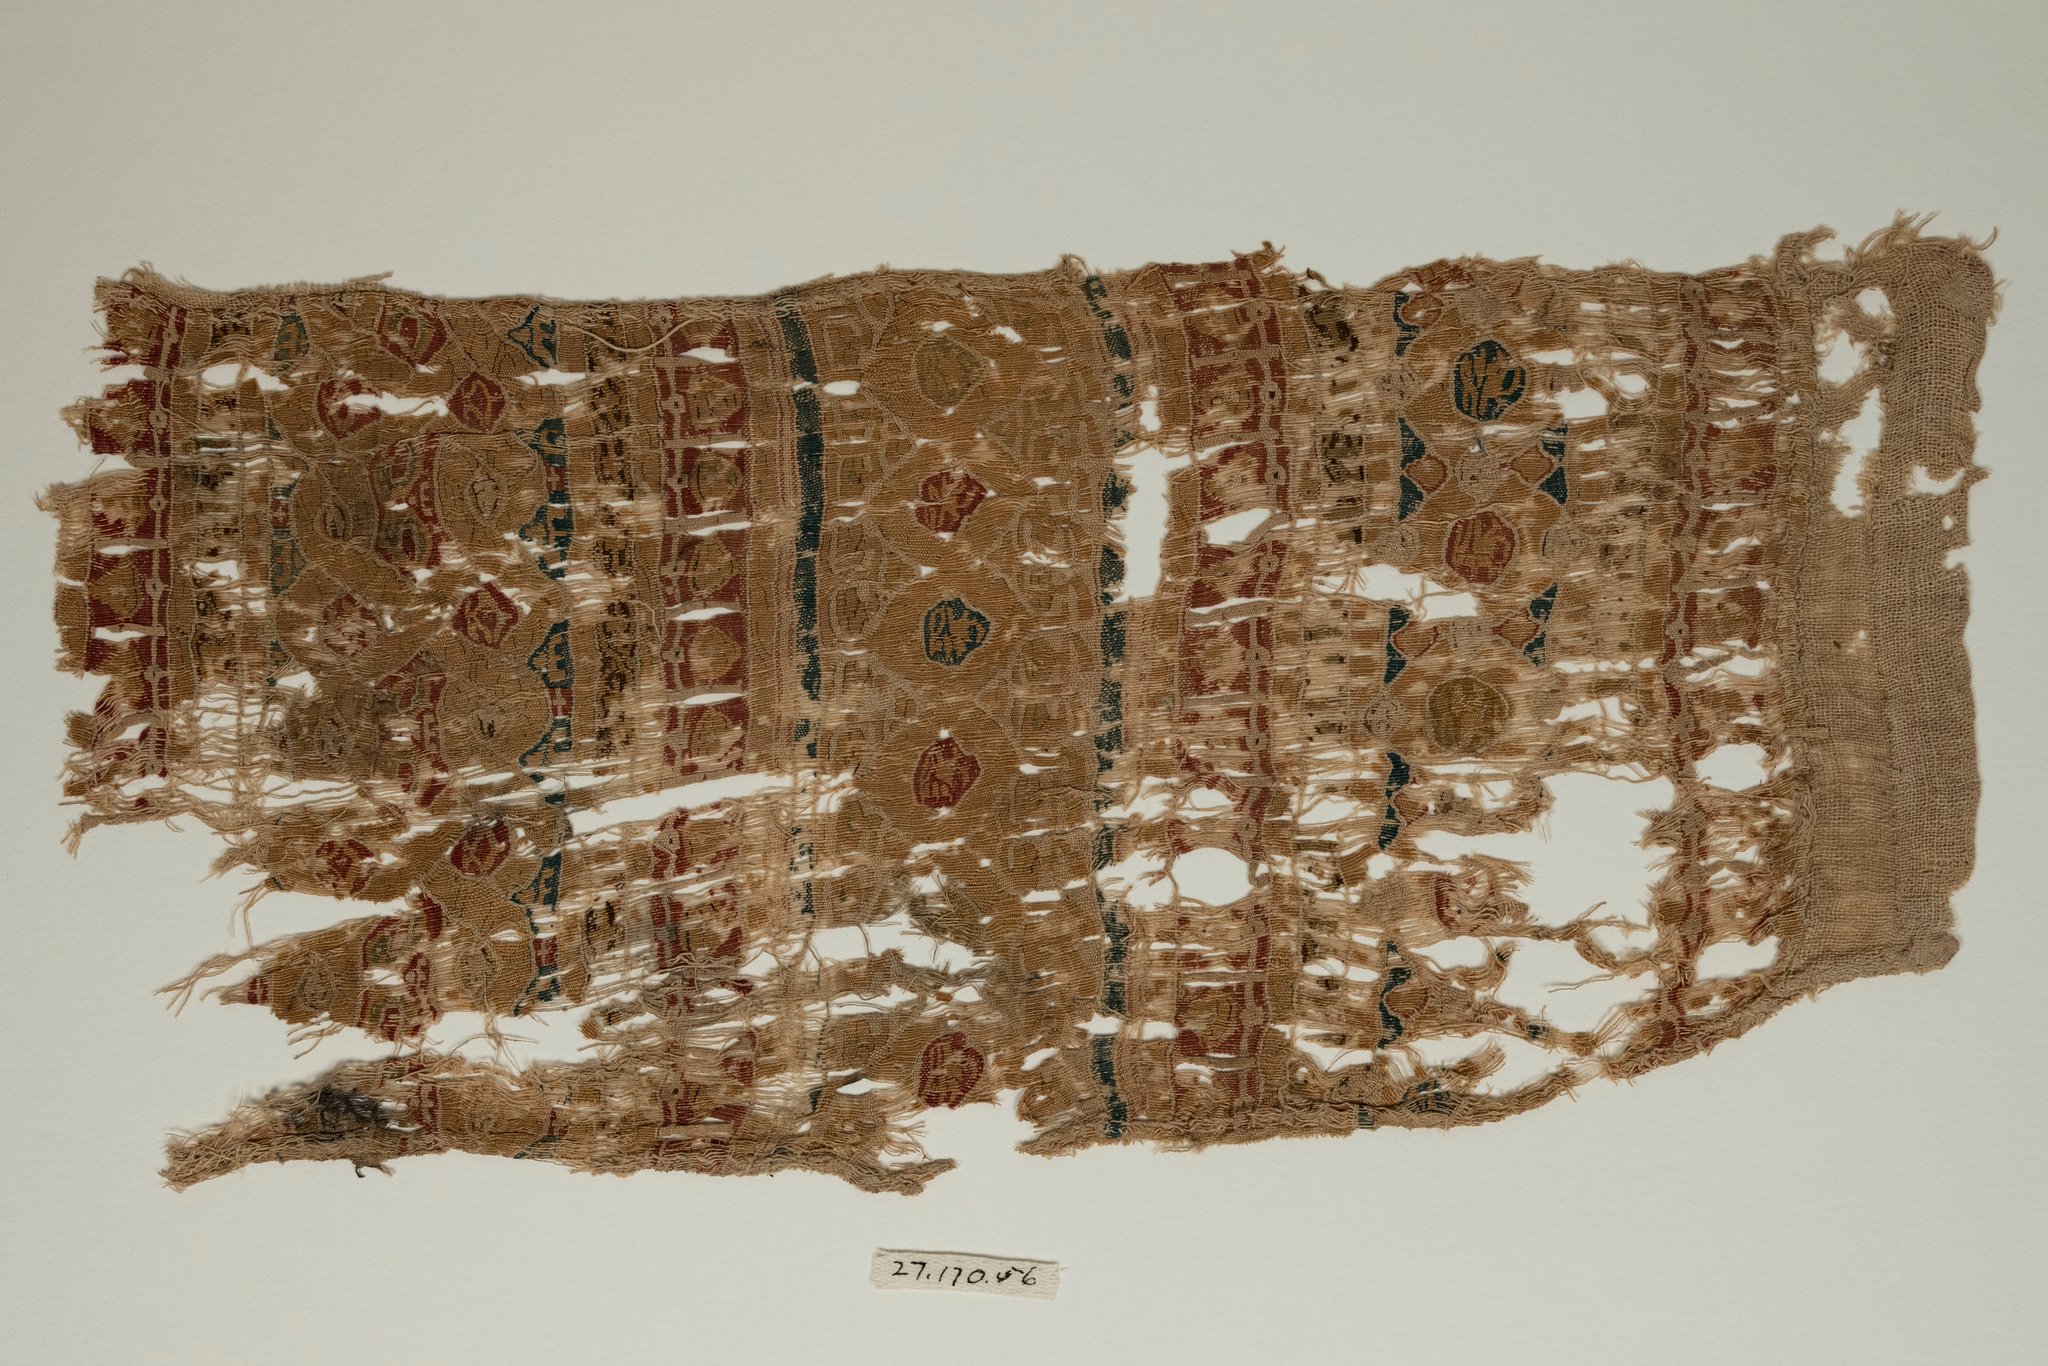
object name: textile fragment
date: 1101-1200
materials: linen, silk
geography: egypt